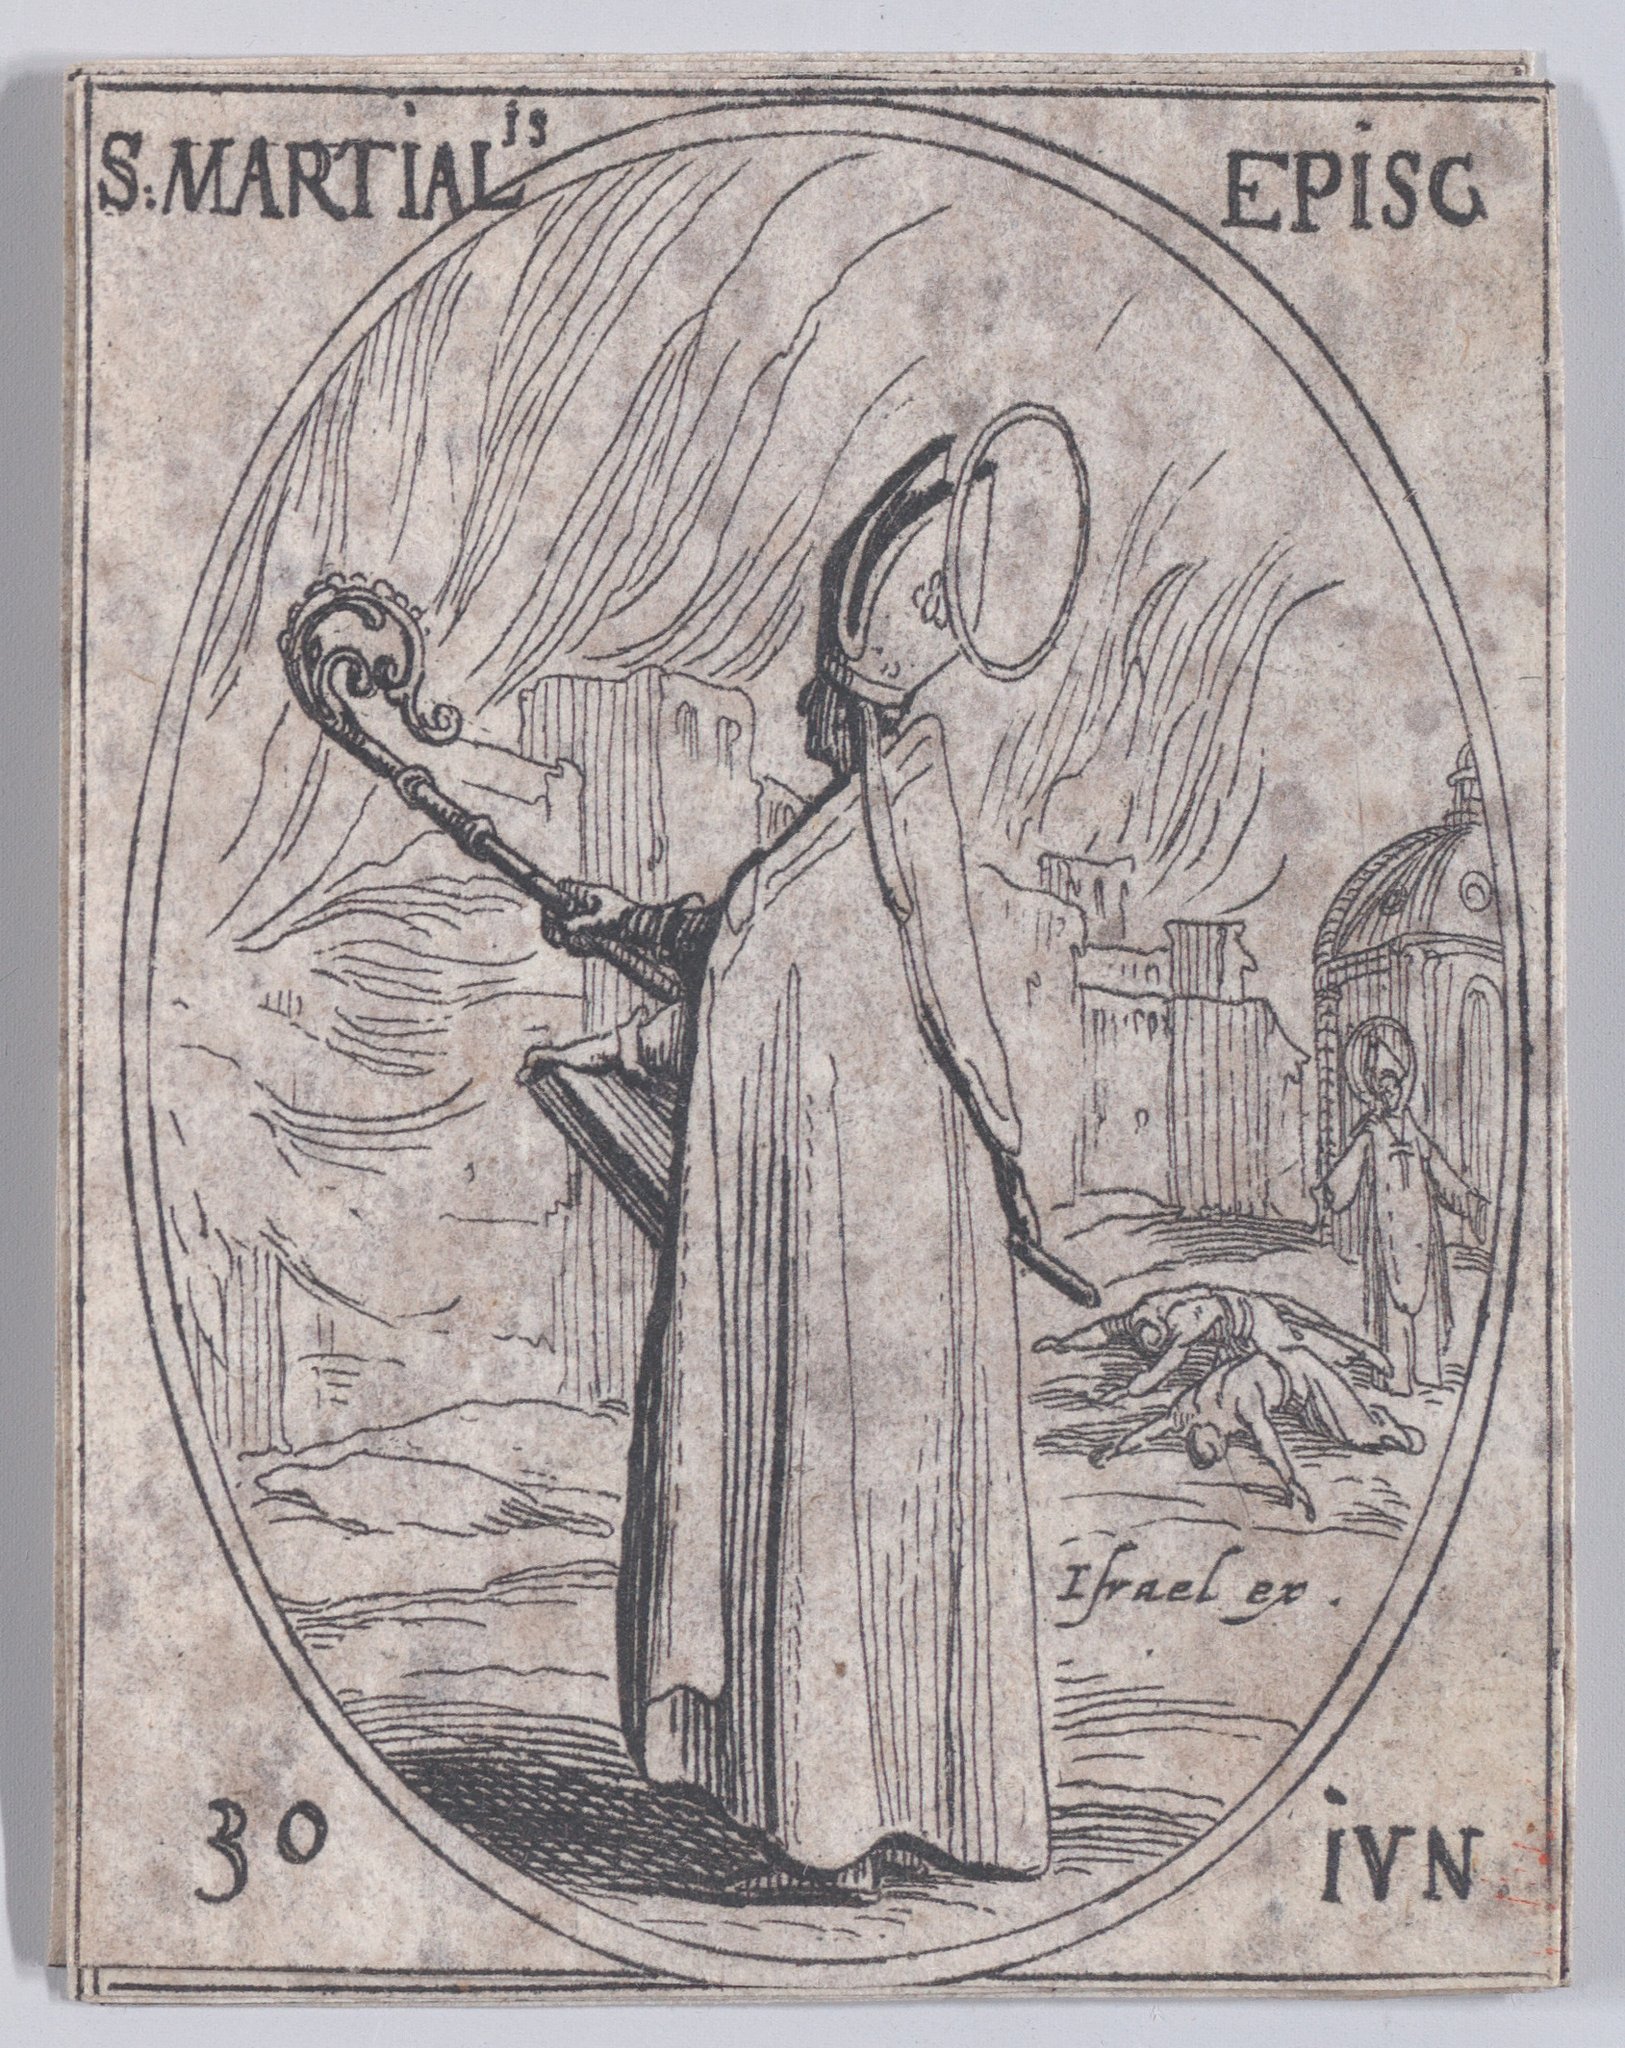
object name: print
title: S. Martial, évêque (St. Martial, Bishop), June 30th, from "Les Images De Tous Les Saincts et Saintes de L'Année" (Images of All of the Saints and Religious Events of the Year)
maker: jacques callot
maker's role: artist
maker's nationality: french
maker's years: 1592-1635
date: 1636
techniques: etching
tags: men,bishops,saints